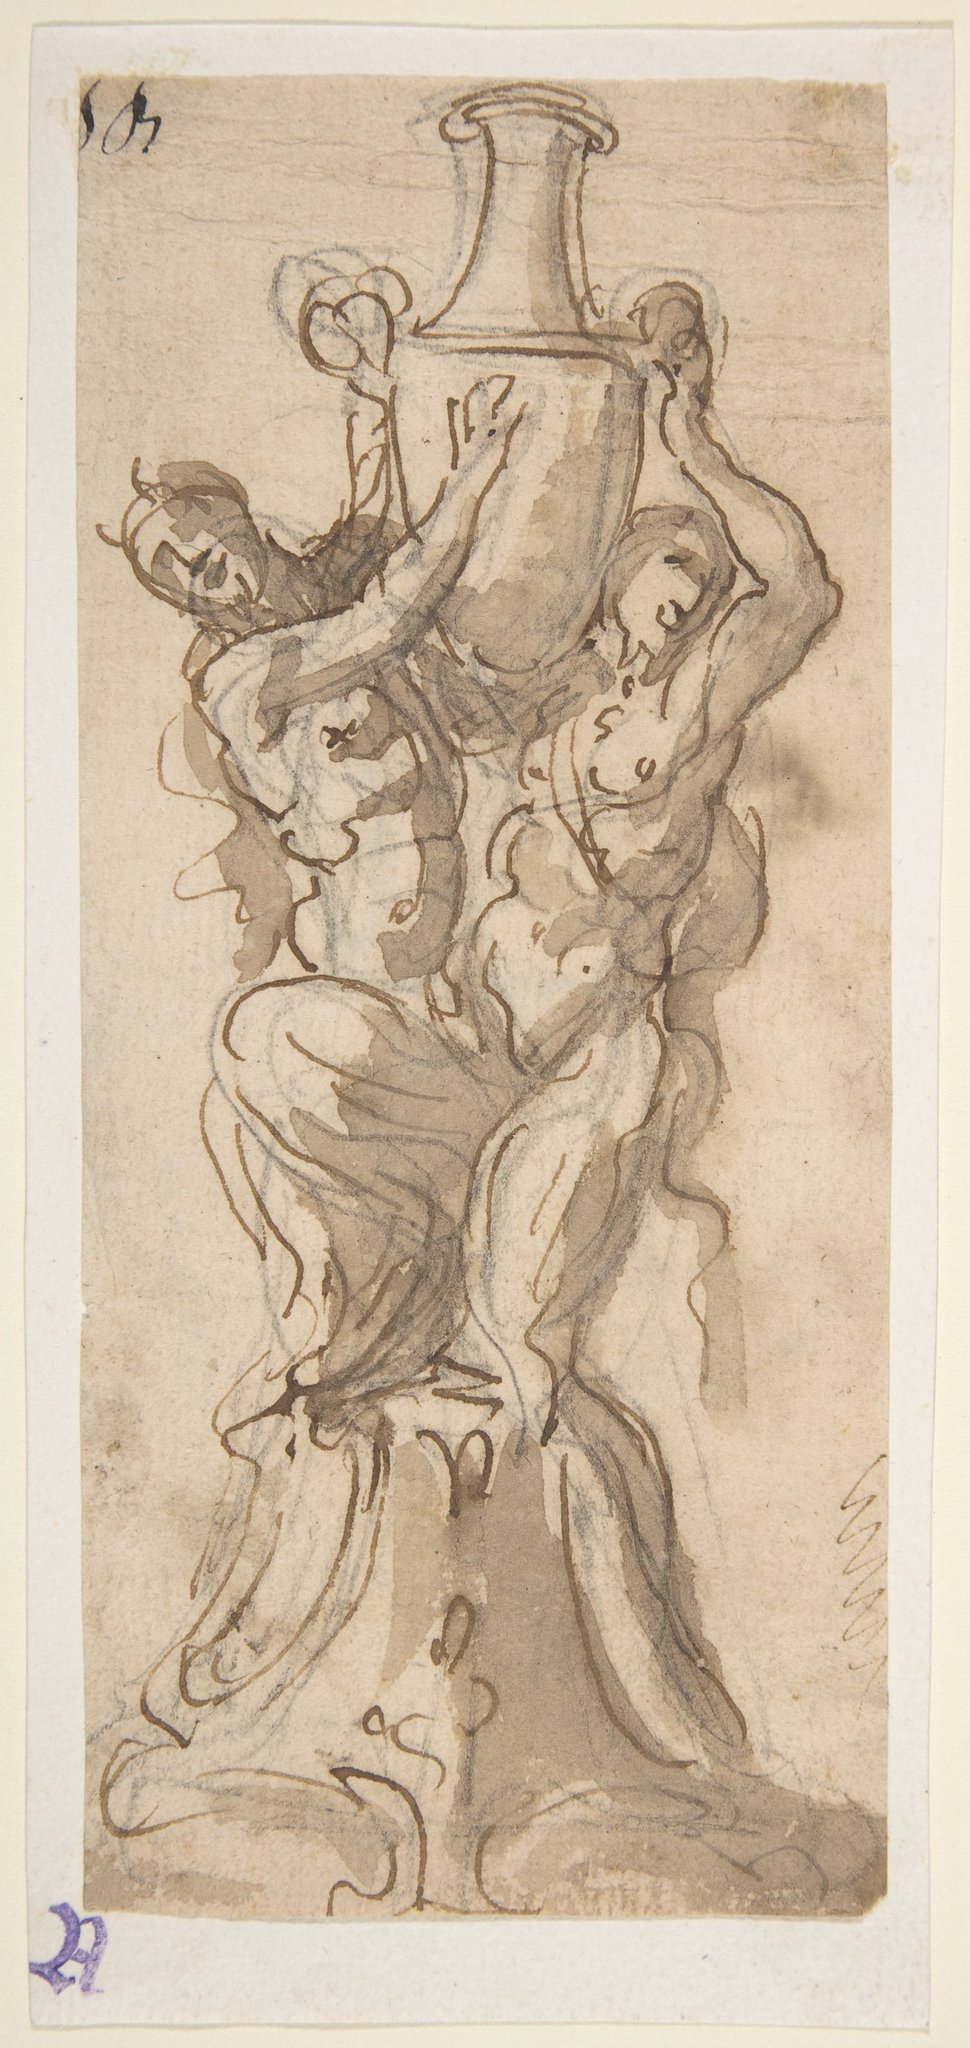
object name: drawing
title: Design for a Statue consisting of a Satyr and Satyress Lifting a Vase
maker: giovanni battista foggini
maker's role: artist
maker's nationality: italian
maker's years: 1652-1725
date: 1672-1725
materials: chalk, ink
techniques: brush, pen, wash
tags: satyrs,vases